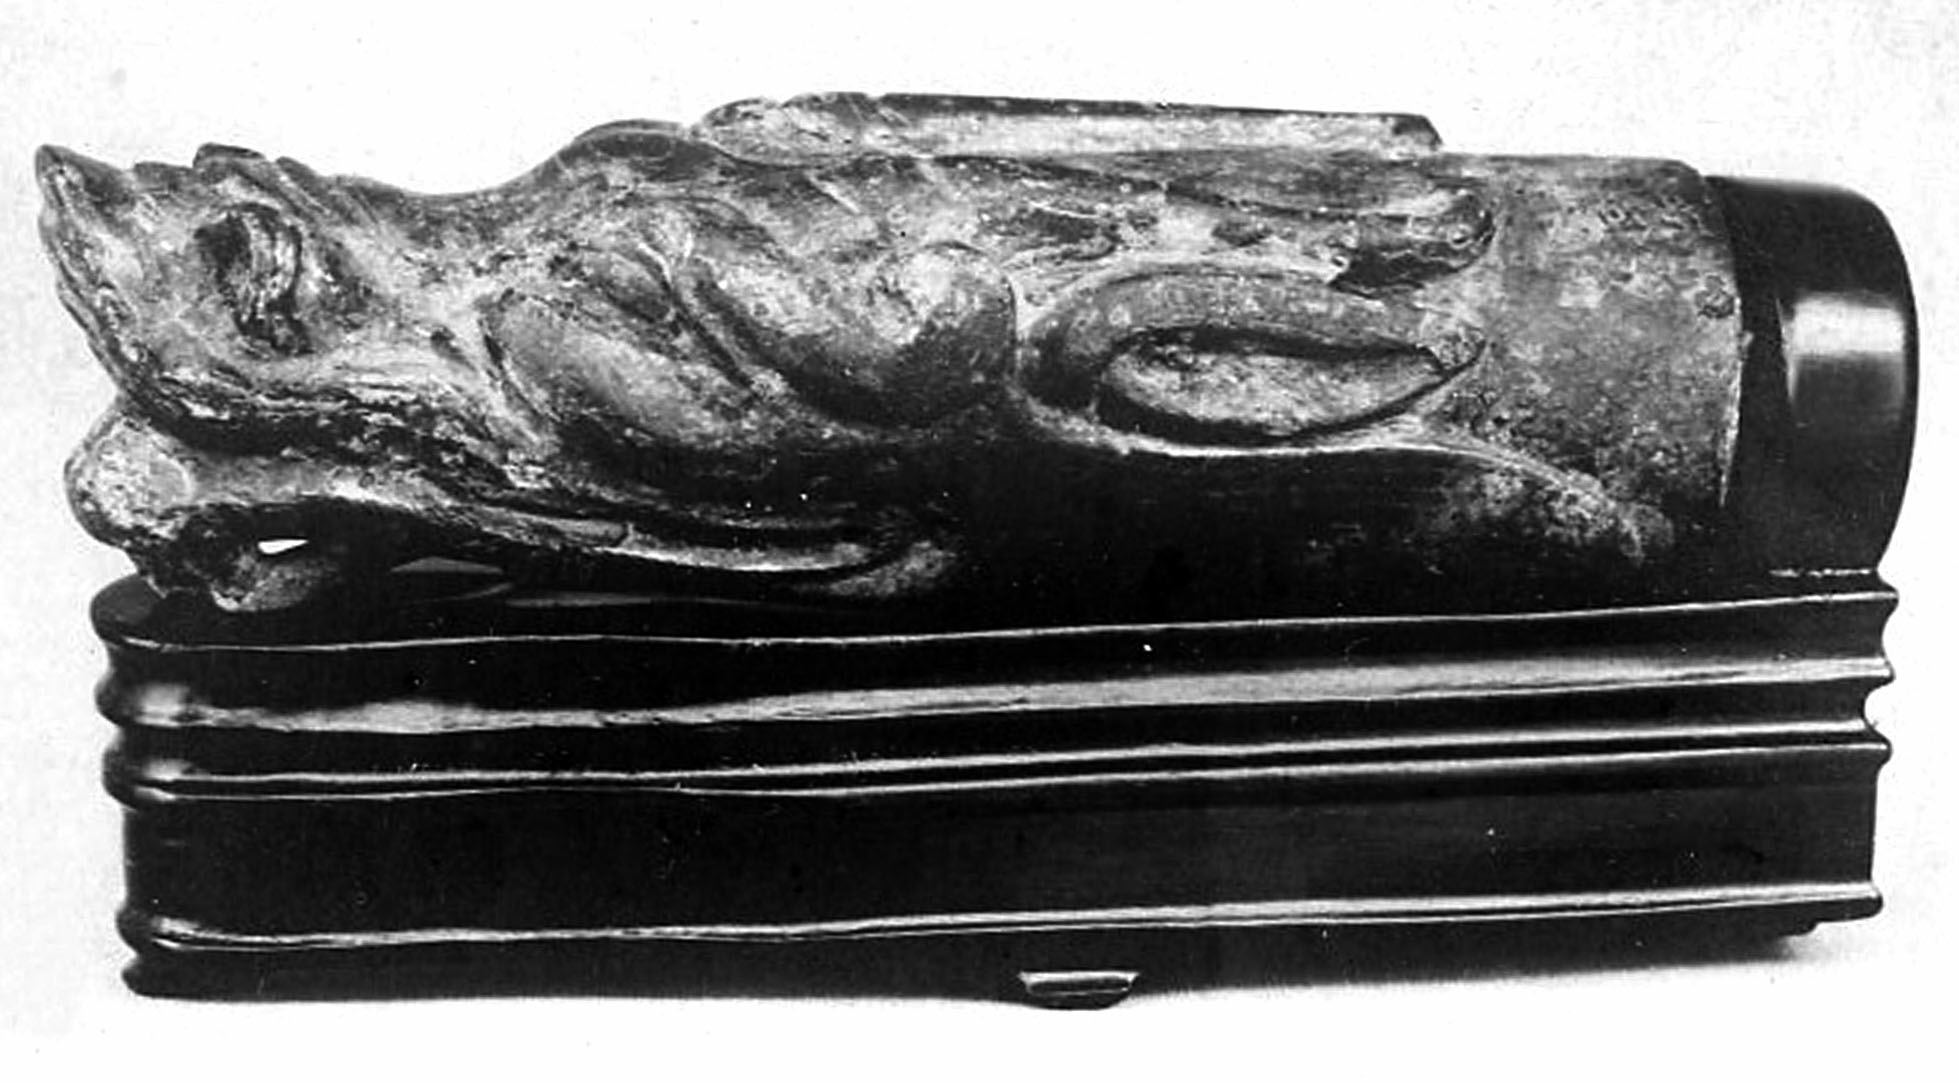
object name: finial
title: Finial in shape of dragon’s head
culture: chinese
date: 618-907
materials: bronze